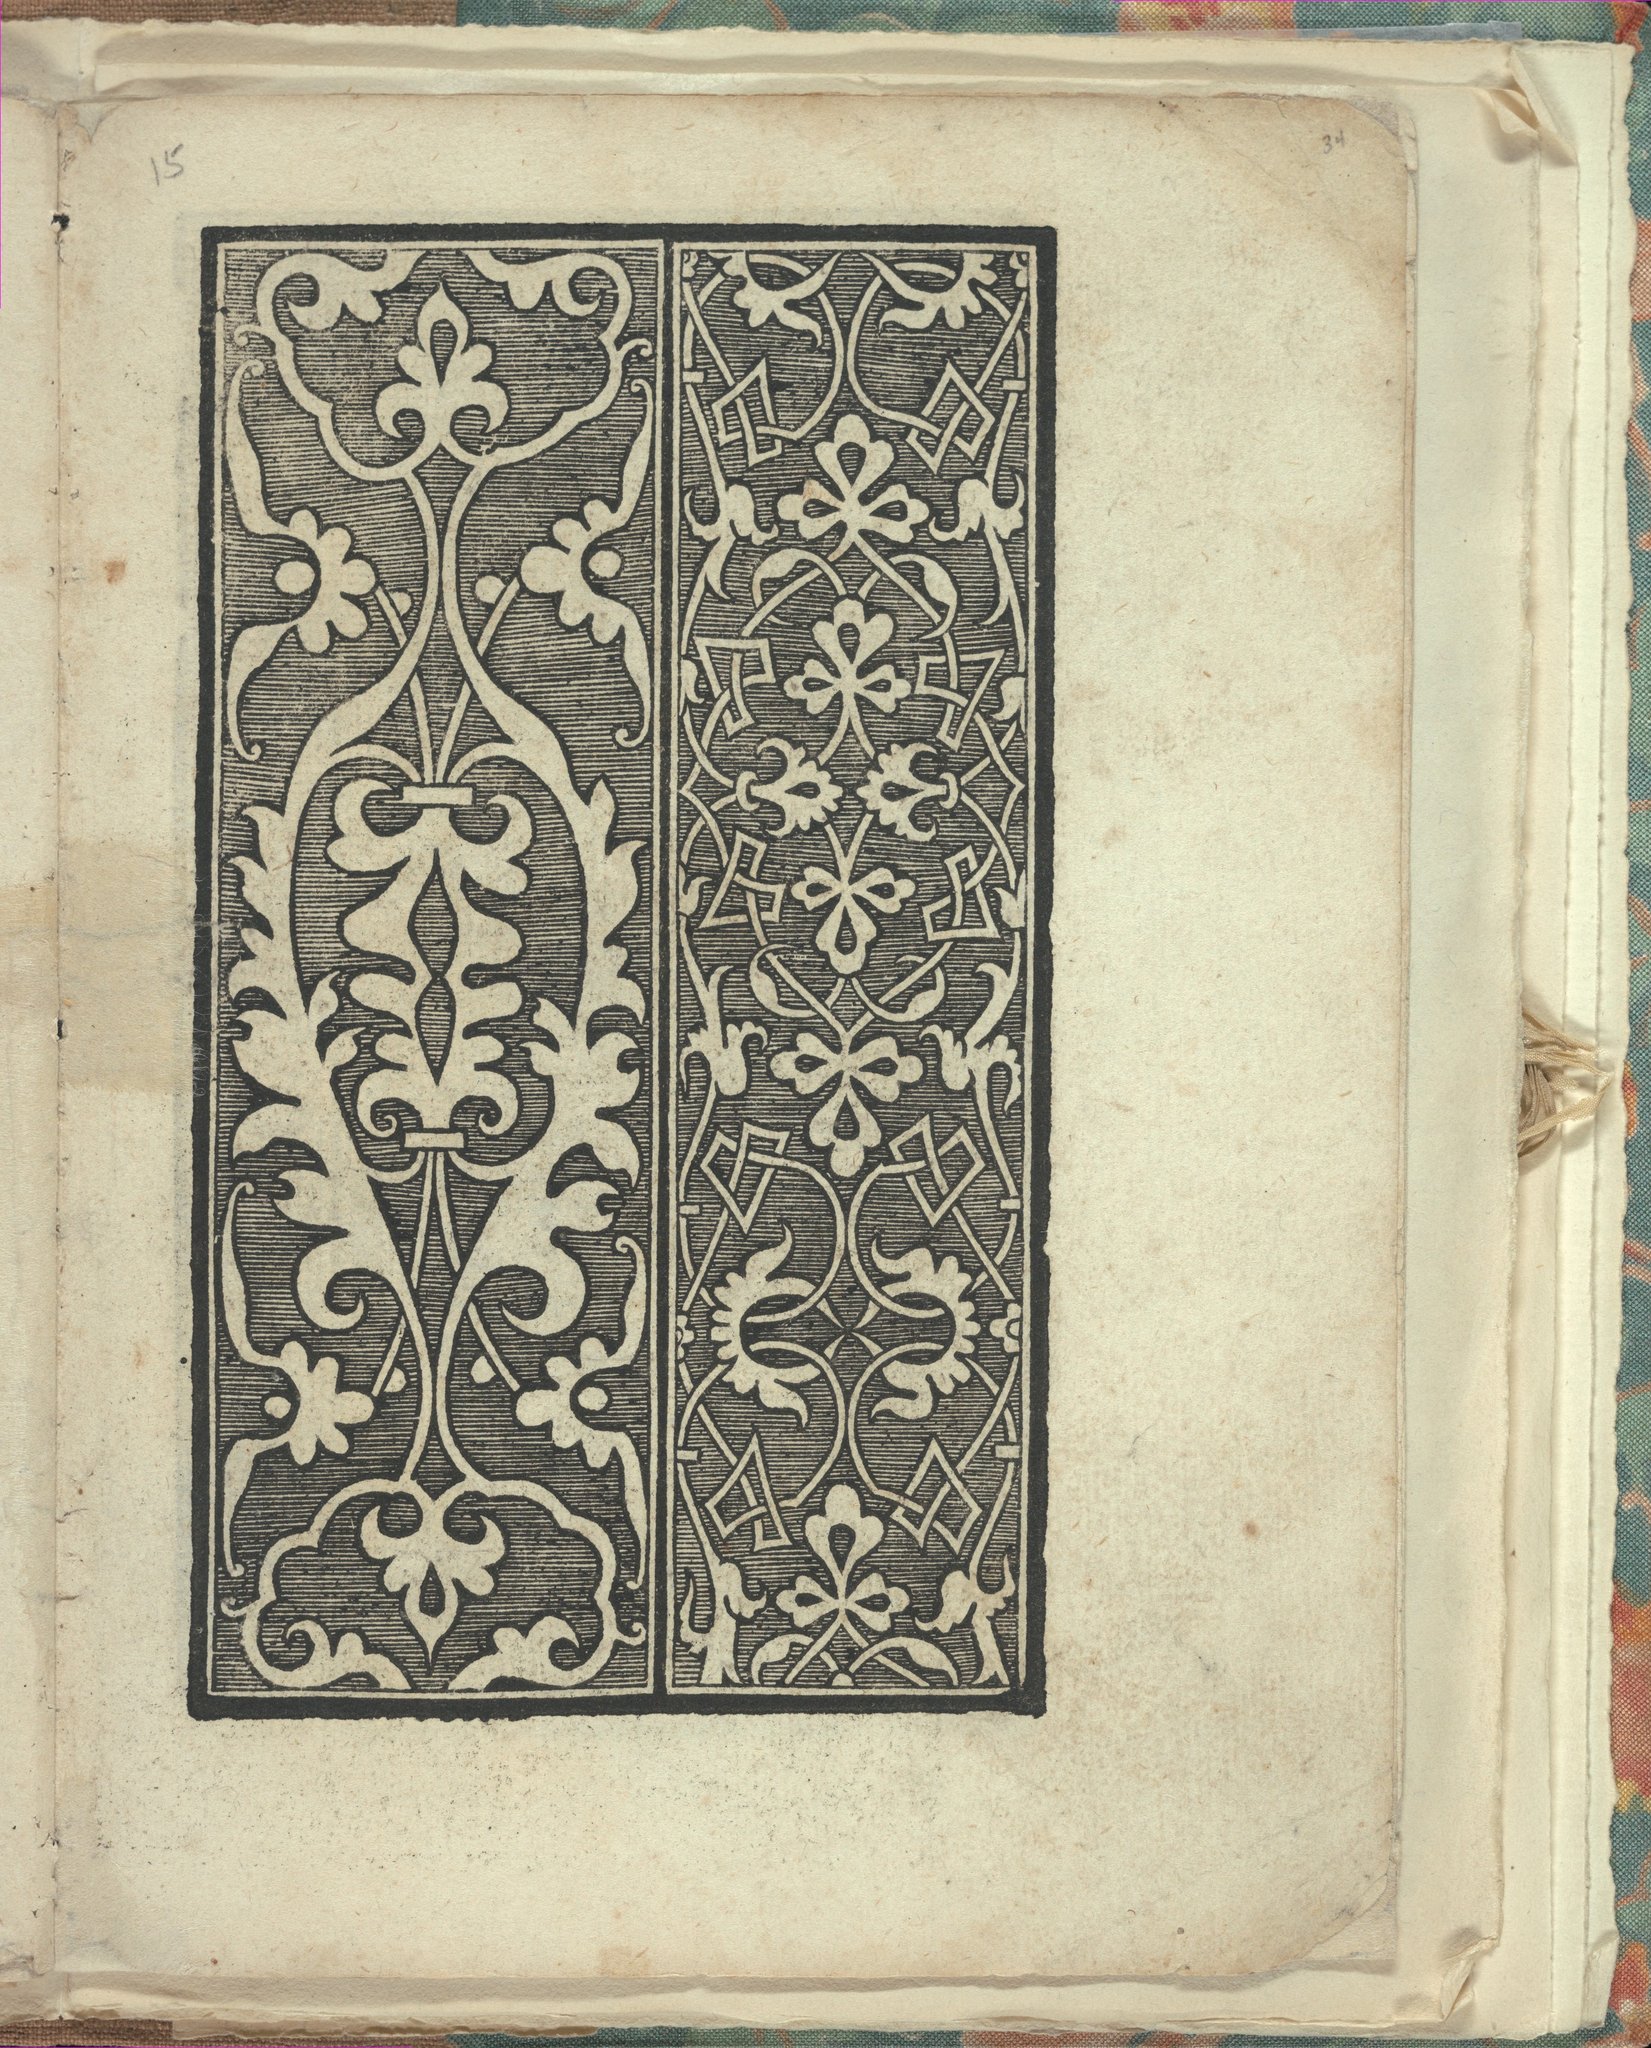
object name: book print ornament architecture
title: Opera Nova Universali intitulata Corona di racammi, page 34 (recto)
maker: giovanni andrea vavassore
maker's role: publisher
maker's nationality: italian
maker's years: 1530-1573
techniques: woodcut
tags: flowers